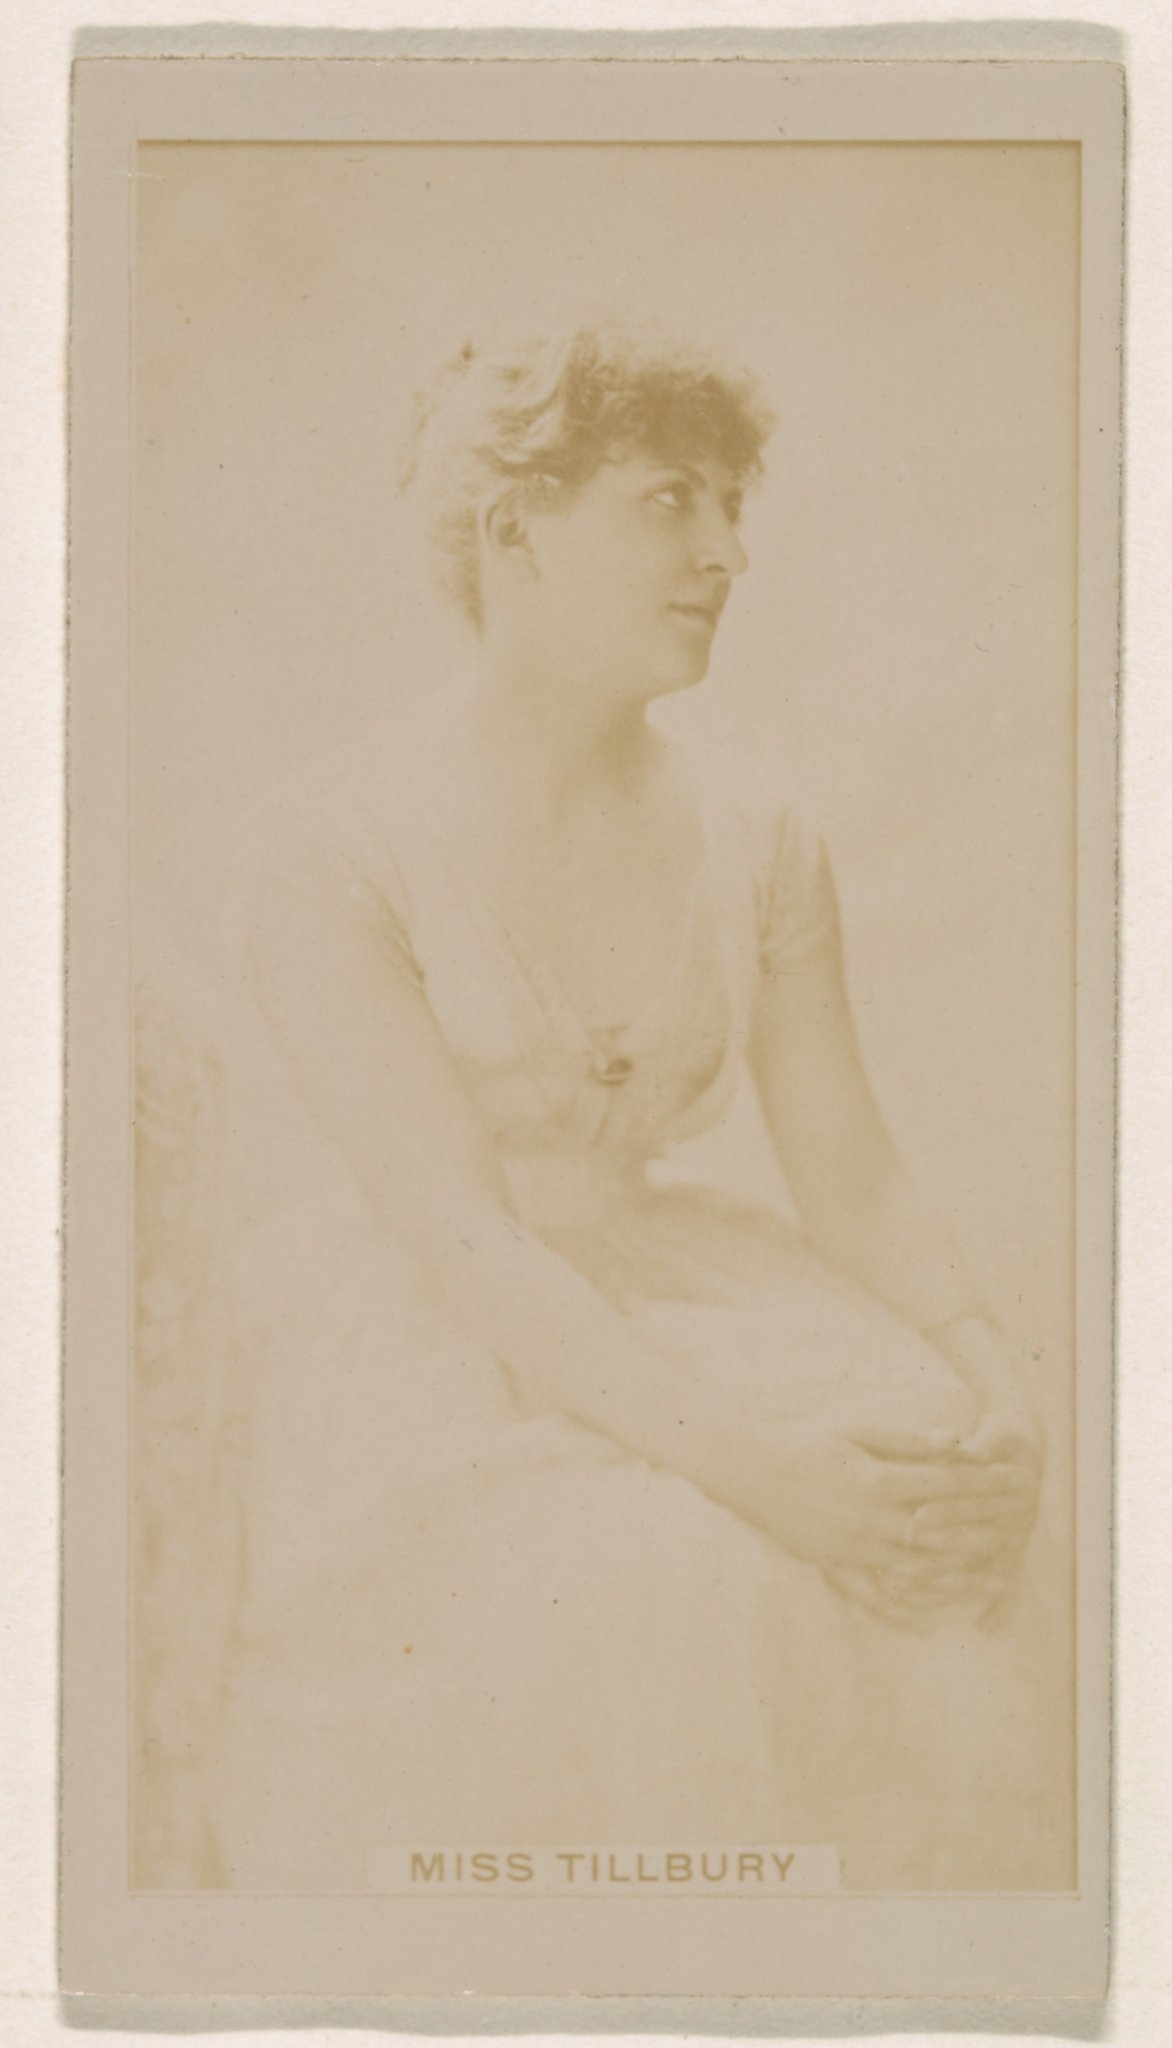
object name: photograph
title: Miss Tillbury, from the Actresses series (N245) issued by Kinney Brothers to promote Sweet Caporal Cigarettes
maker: kinney brothers tobacco company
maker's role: publisher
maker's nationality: american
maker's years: 1869-2011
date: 1890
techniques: albumen silver print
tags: women,actresses